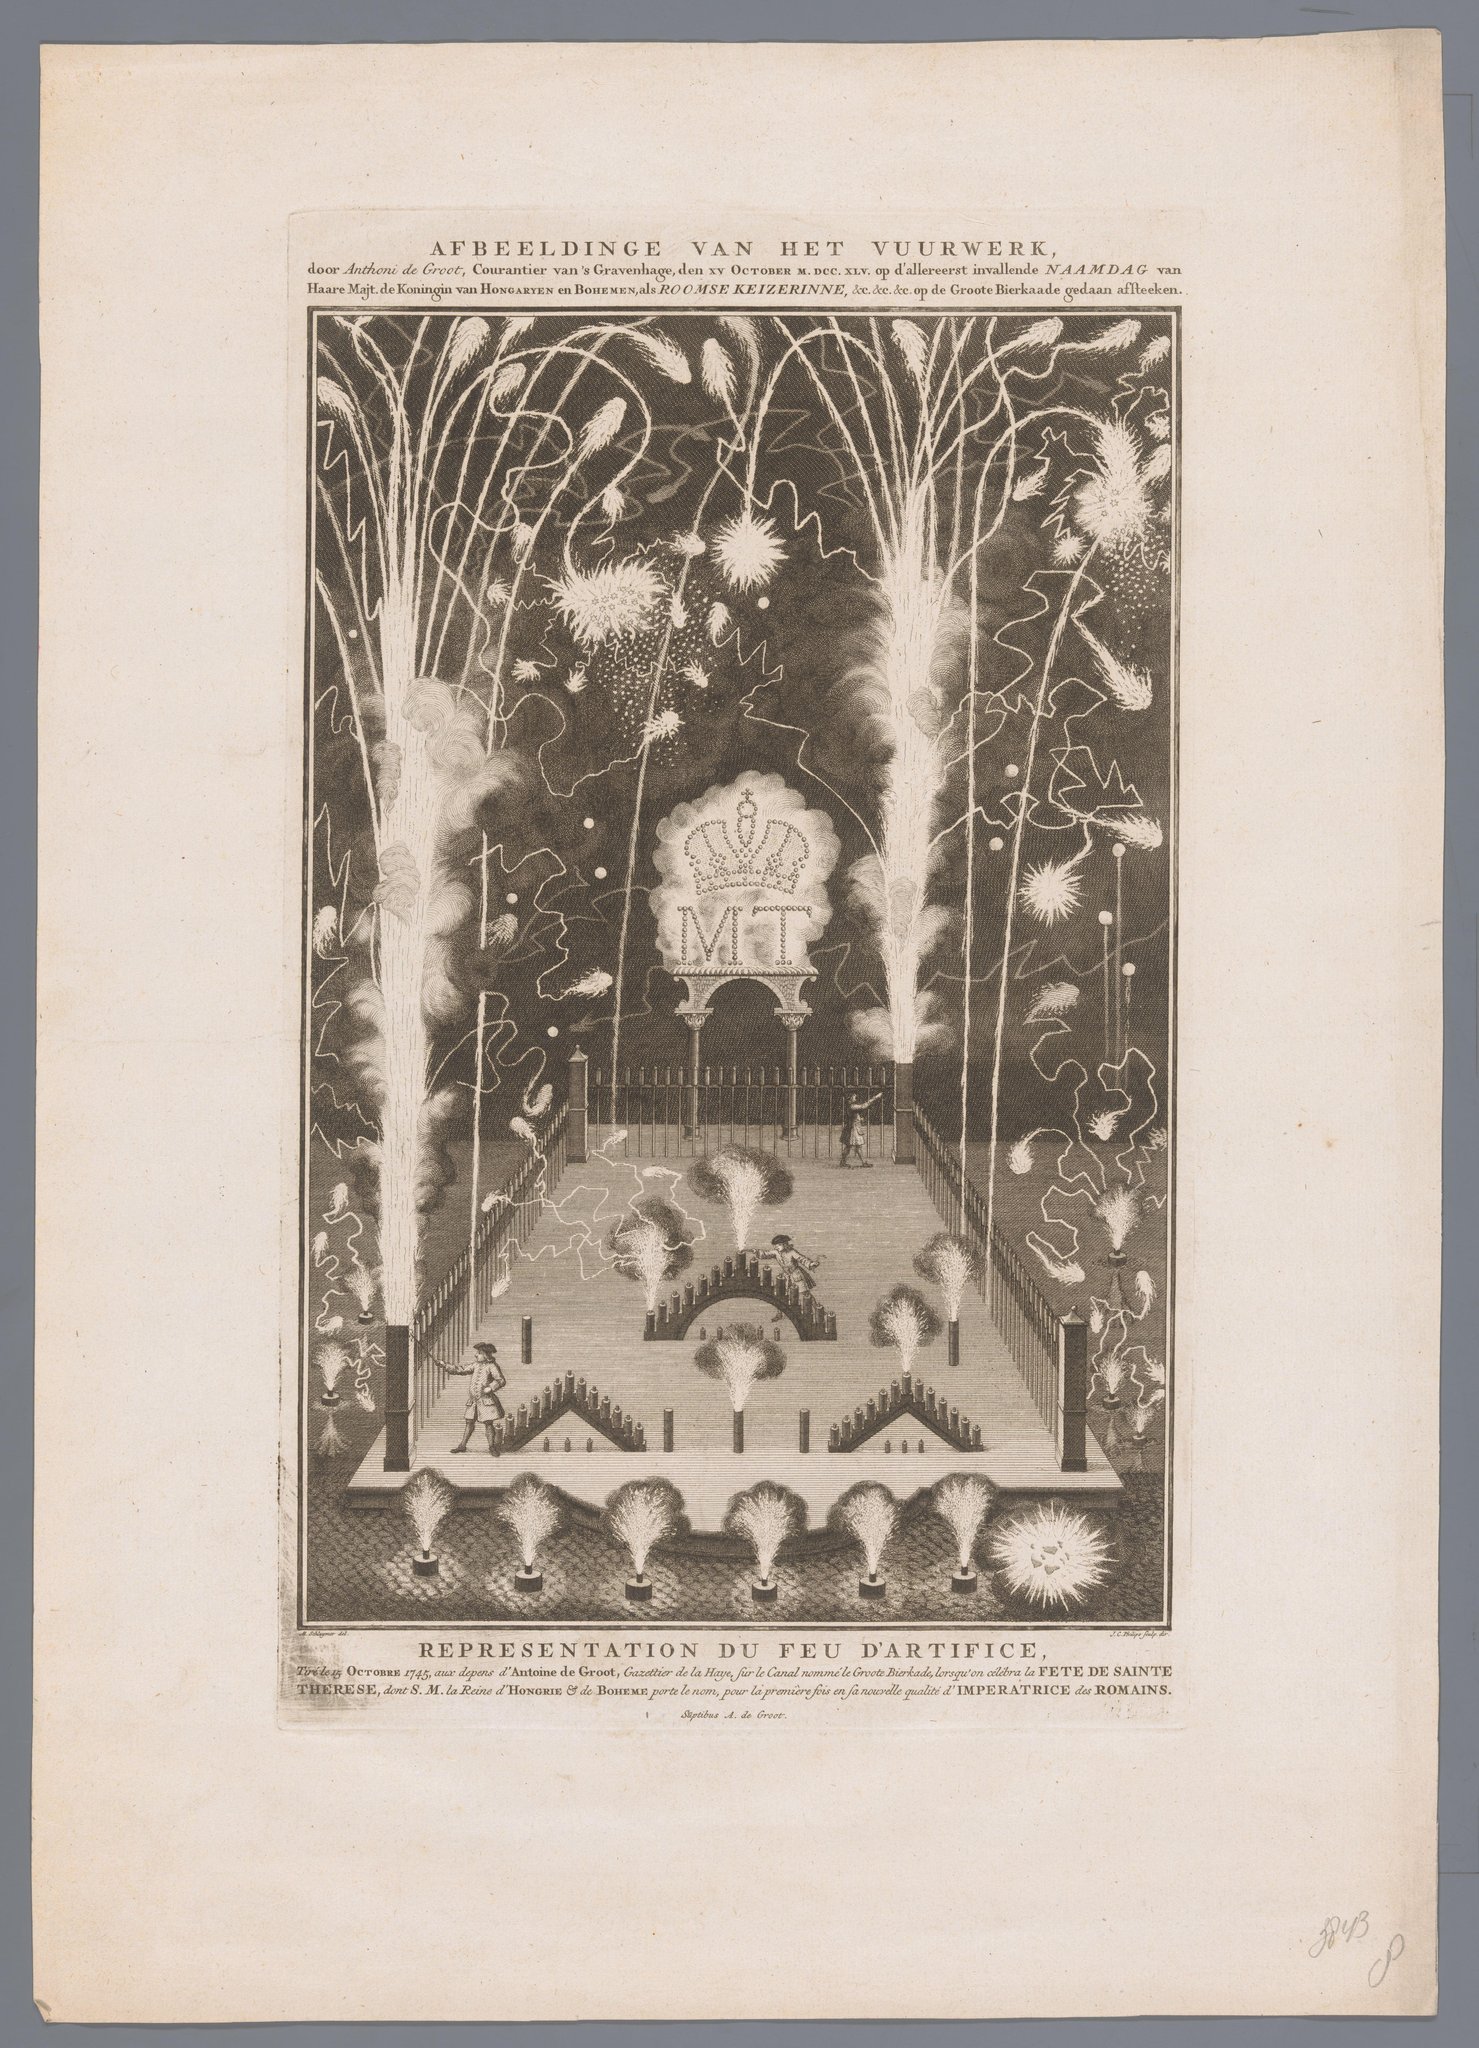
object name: print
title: Afbeeldinge van het Vuurwerk, door Anthoni de Groot, Courantier van 's Gravenhage, den XV October MDCCXLV op d'allereerst invallende Naamdag van Haare Majt. de Koningin van Hongaryen en Bohemen, als Roomse Keizerinne (...) op de Groote Bierkaade gedaan afsteeken / Representation du Feu d'Artifice, Tiré le 15 Octobre 1745 (...)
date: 1745-1747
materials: paper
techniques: engraving, etching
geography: the hague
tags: frans i stefan (duits keizer), bonfire, fire-works, the hague